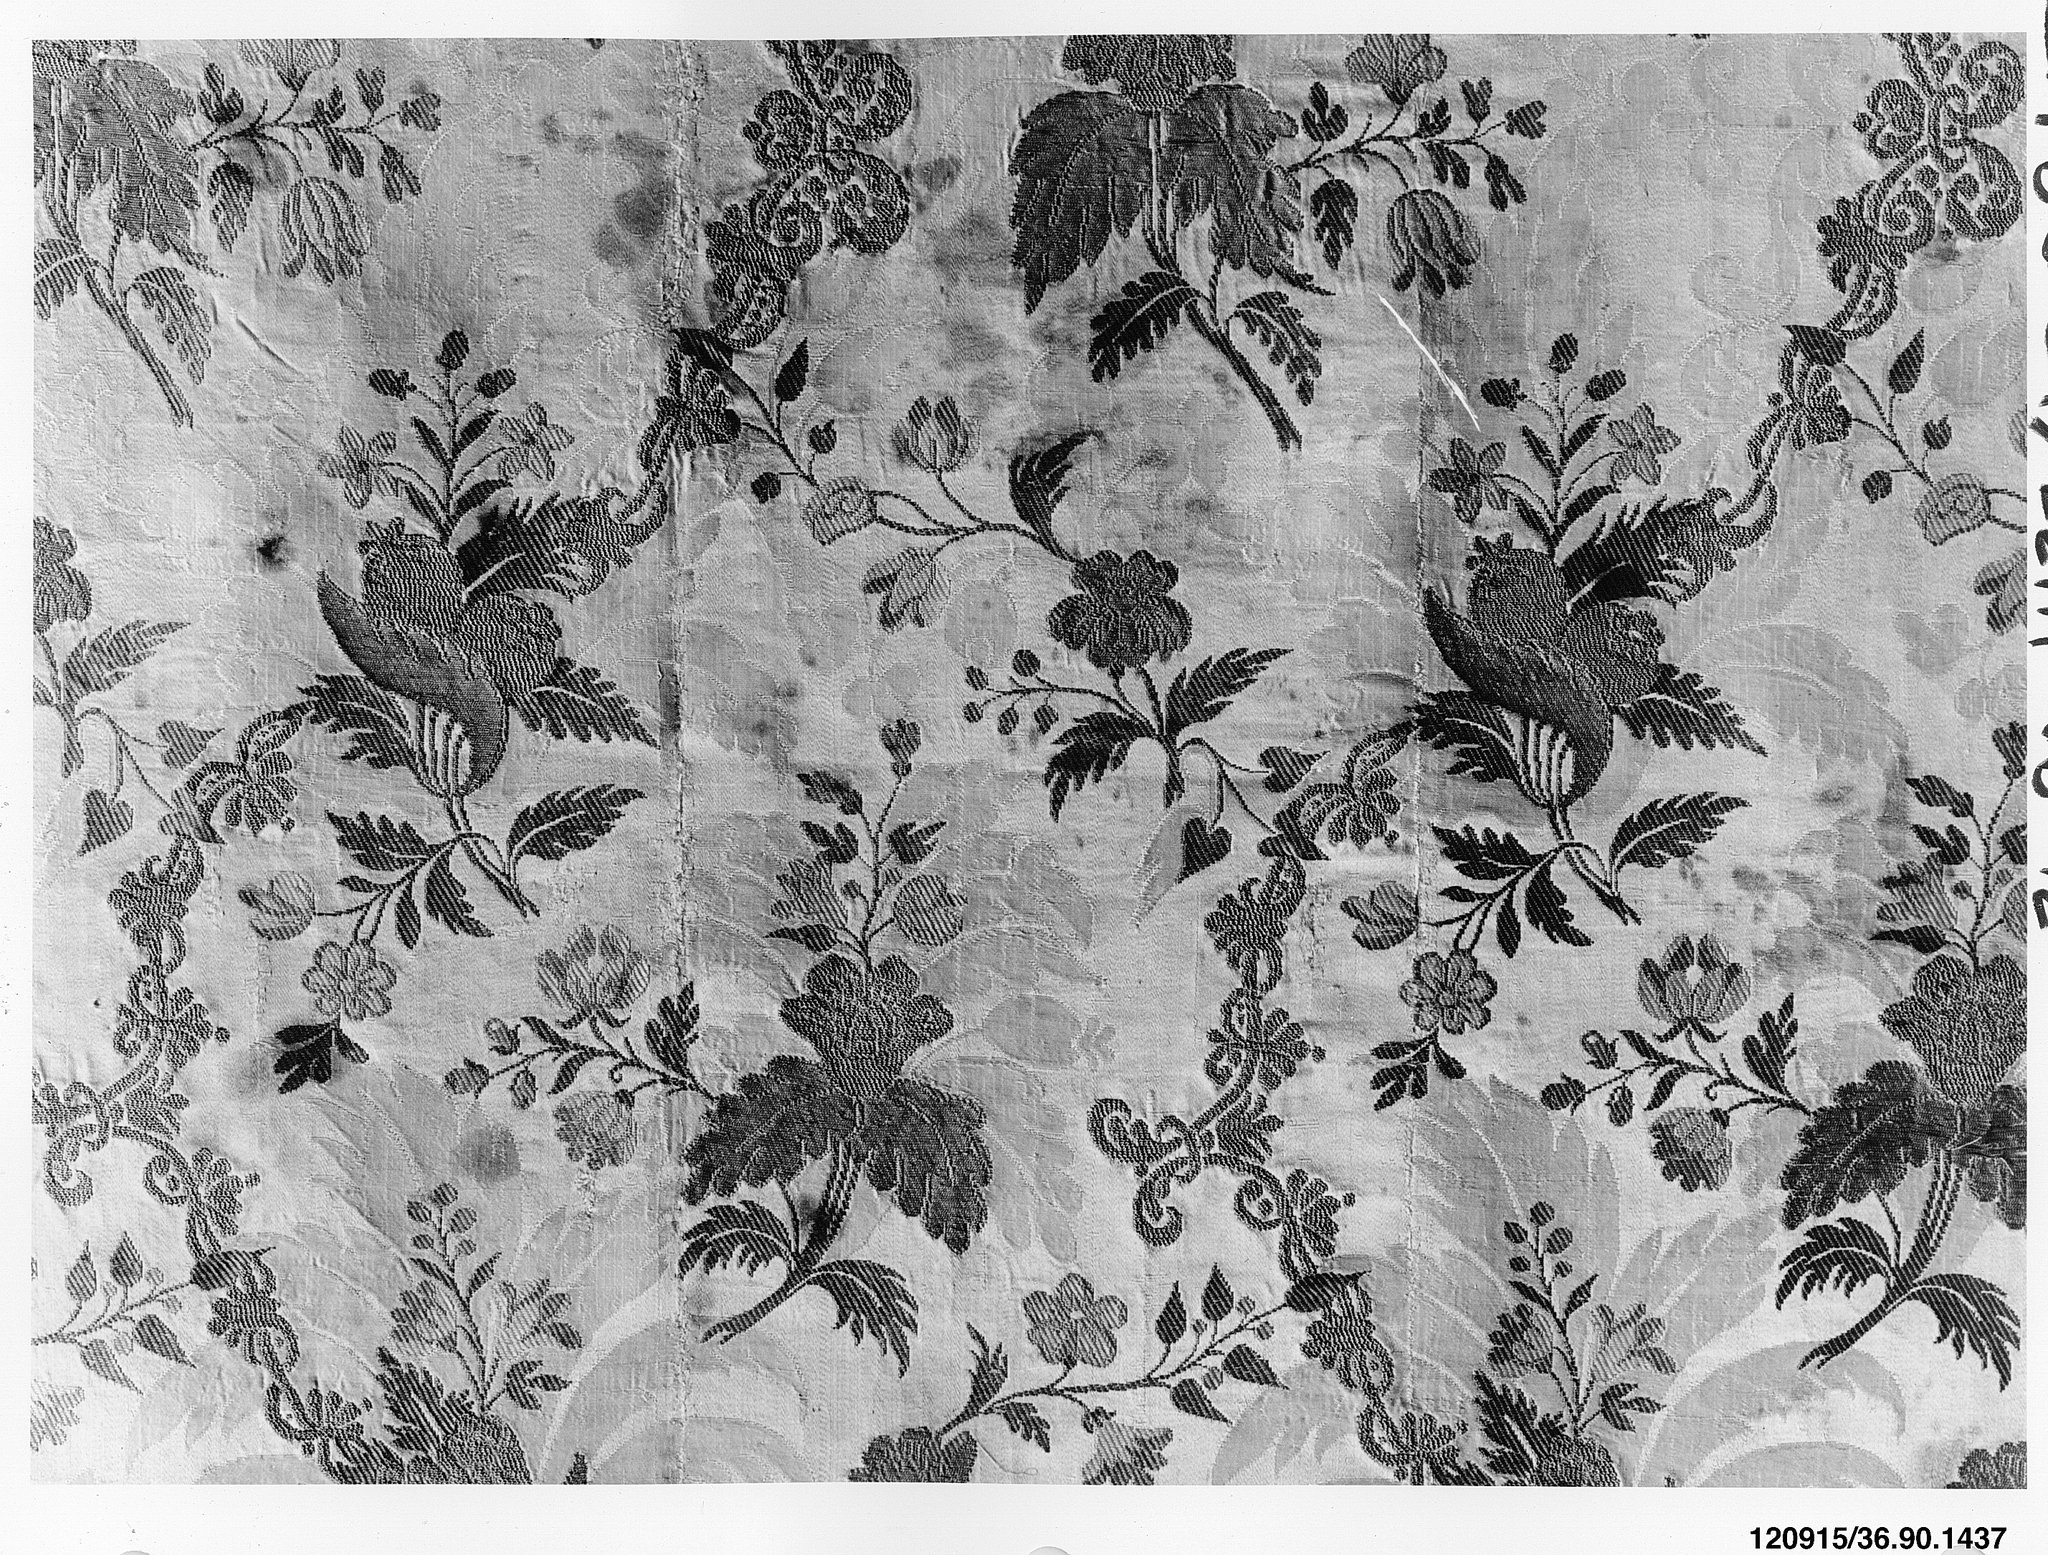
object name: piece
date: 1720-1730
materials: silk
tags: flowers,leaves